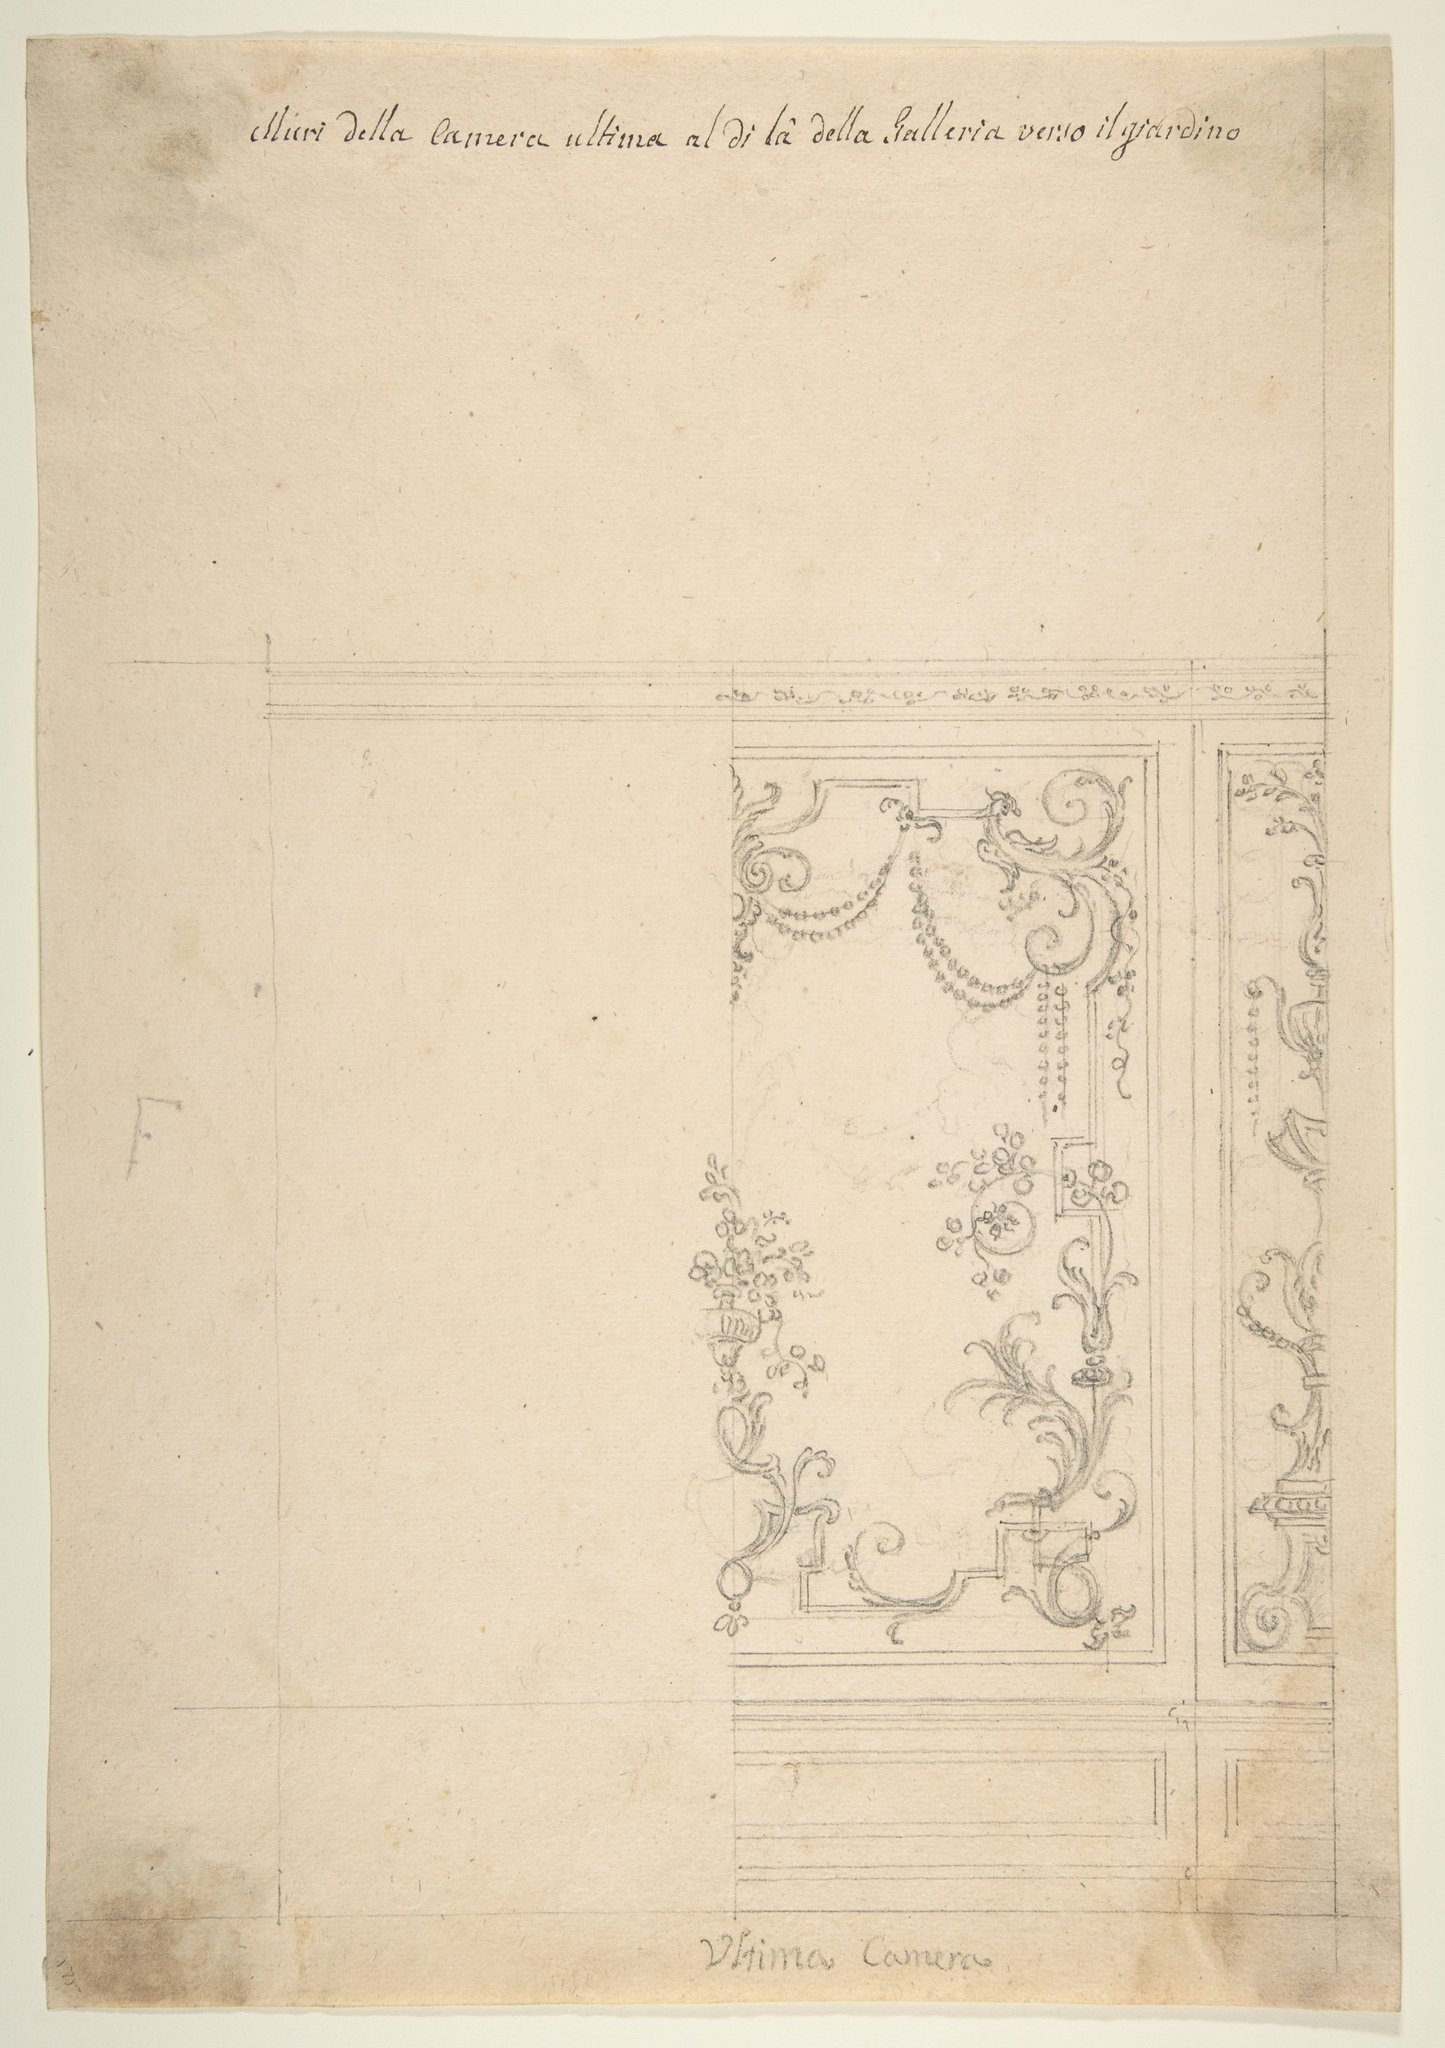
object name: drawing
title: Wall Design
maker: leonardo marini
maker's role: artist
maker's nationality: italian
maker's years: 1730-1797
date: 1701-1800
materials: graphite, drawing material